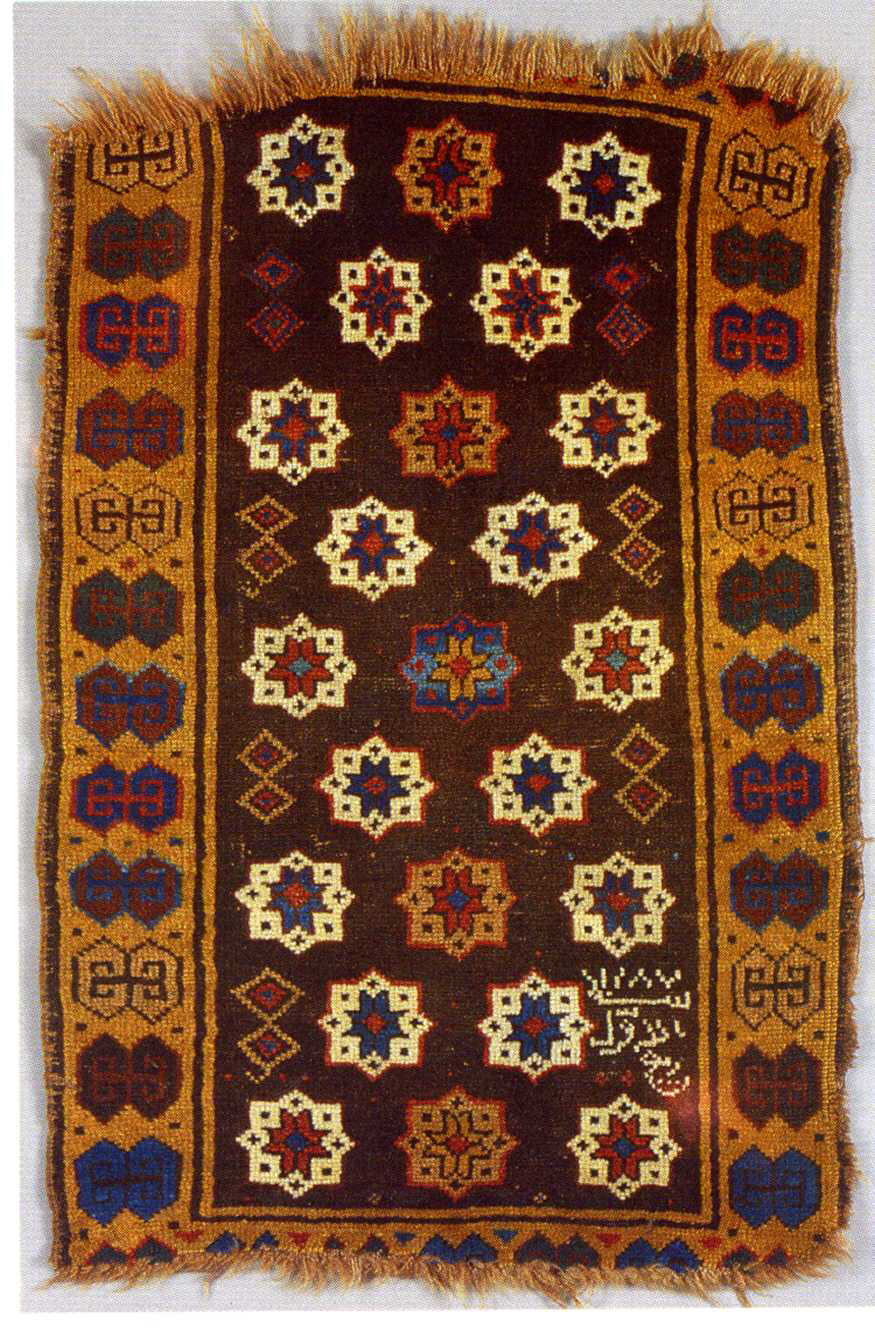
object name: carpet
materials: wool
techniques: pile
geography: turkey